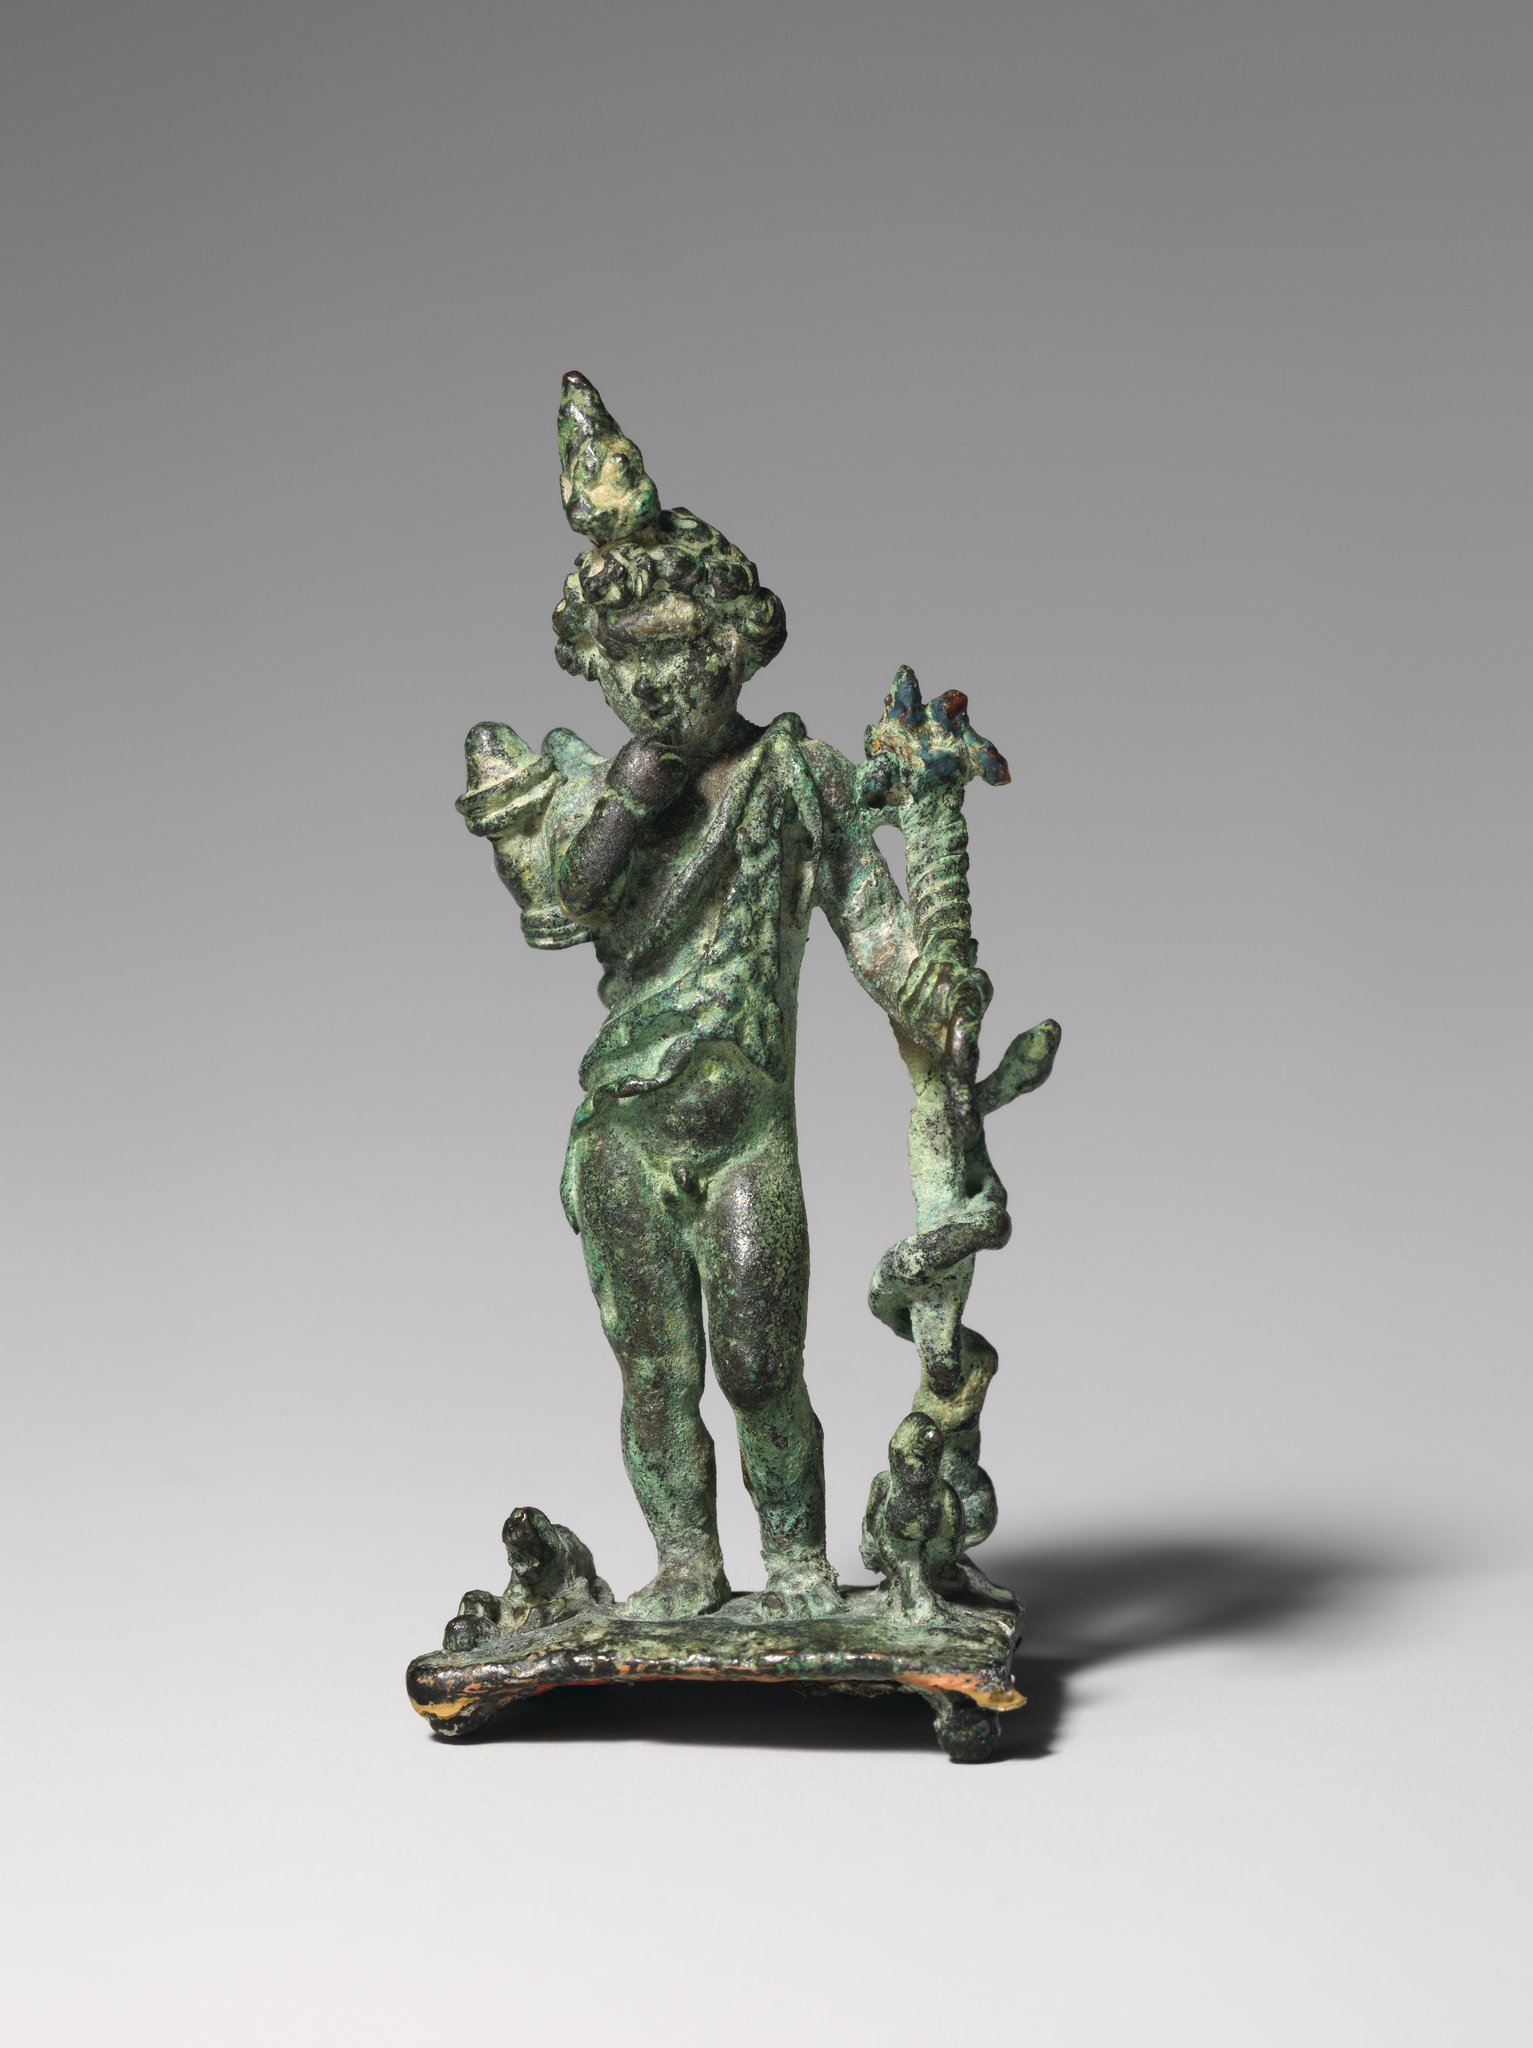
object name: statuette, harpokrates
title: Bronze statuette of Harpokrates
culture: roman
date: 1-200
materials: bronze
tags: harpokrates